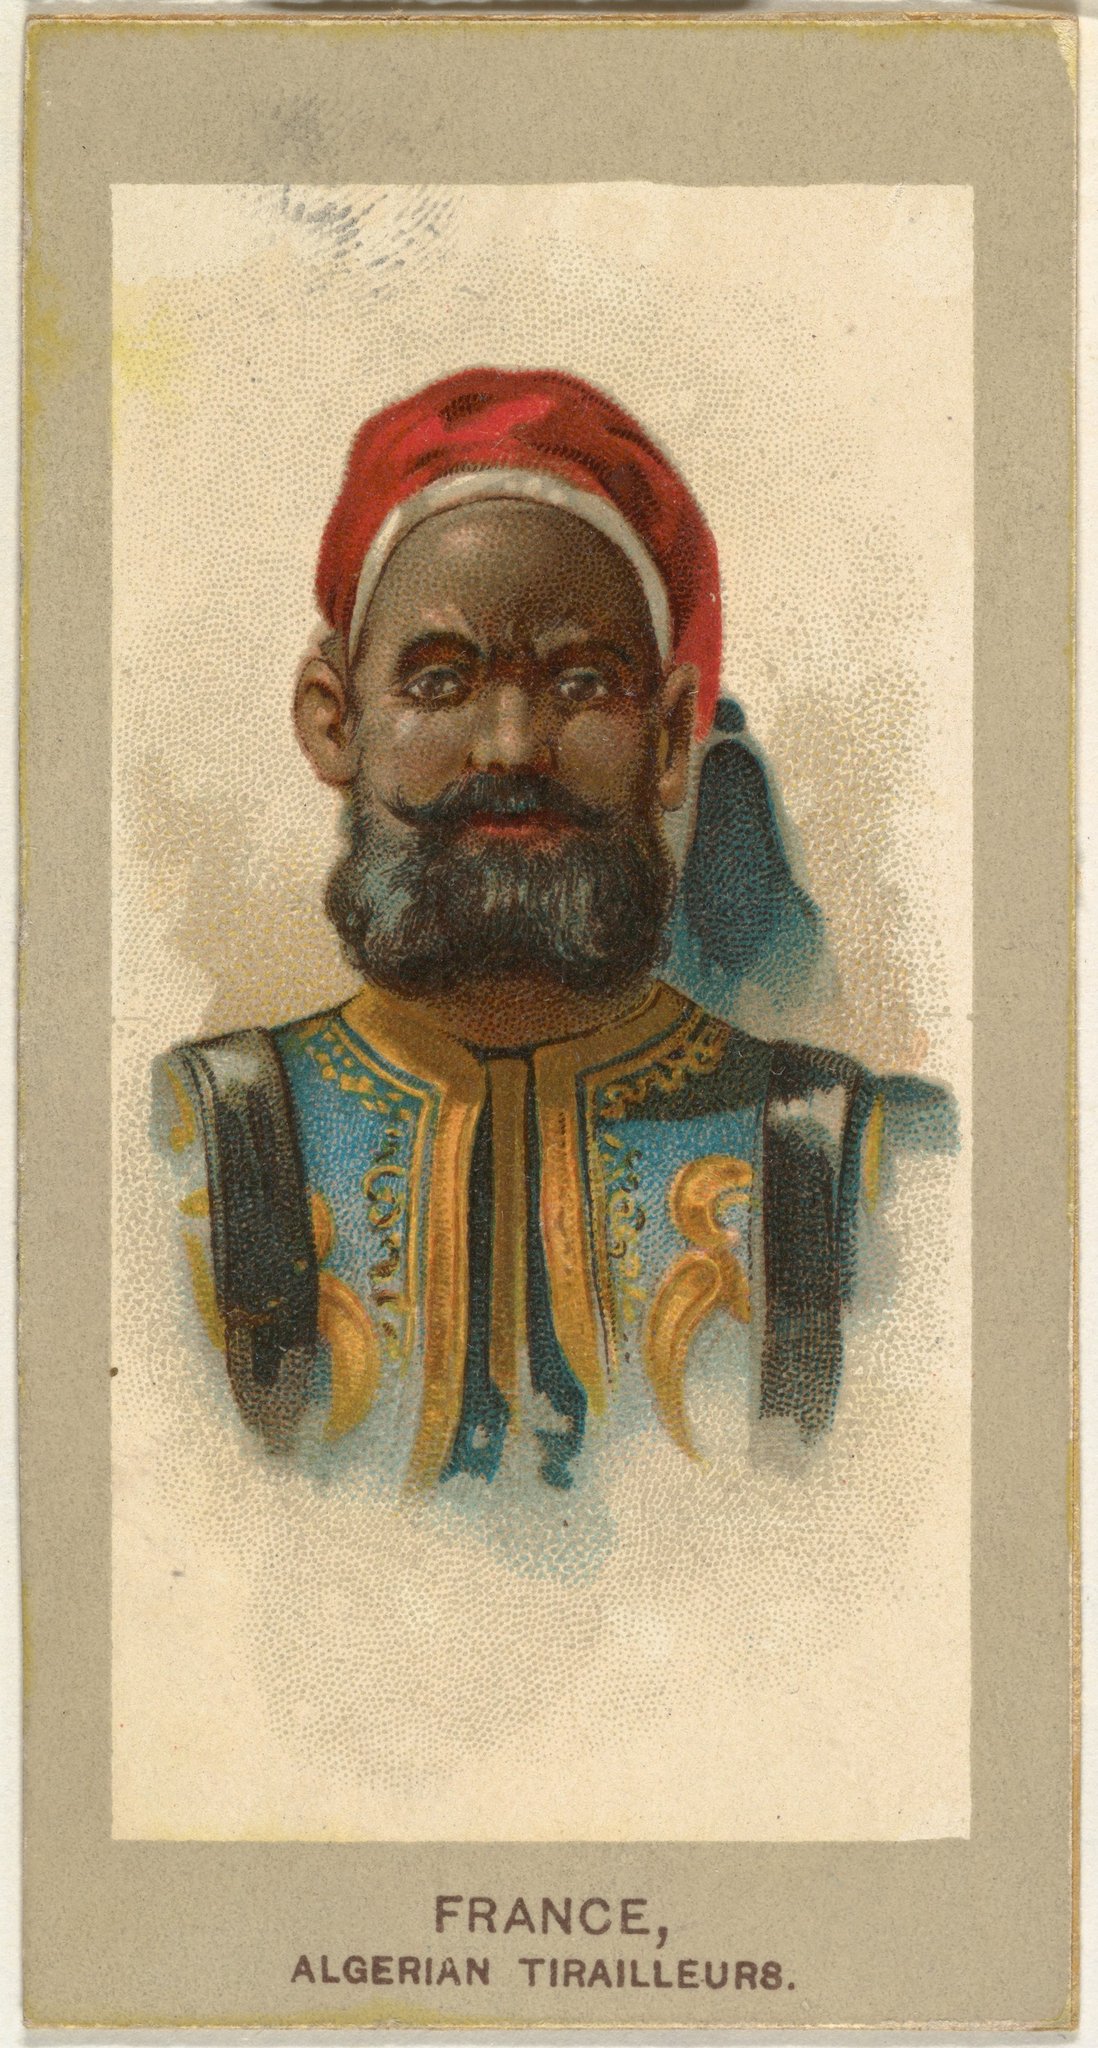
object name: print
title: Algerian Tirailleurs, France, from the Military Uniforms series (T182) issued by Abdul Cigarettes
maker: abdul cigarettes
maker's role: publisher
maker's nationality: american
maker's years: 1881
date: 1881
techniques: color lithograph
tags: men